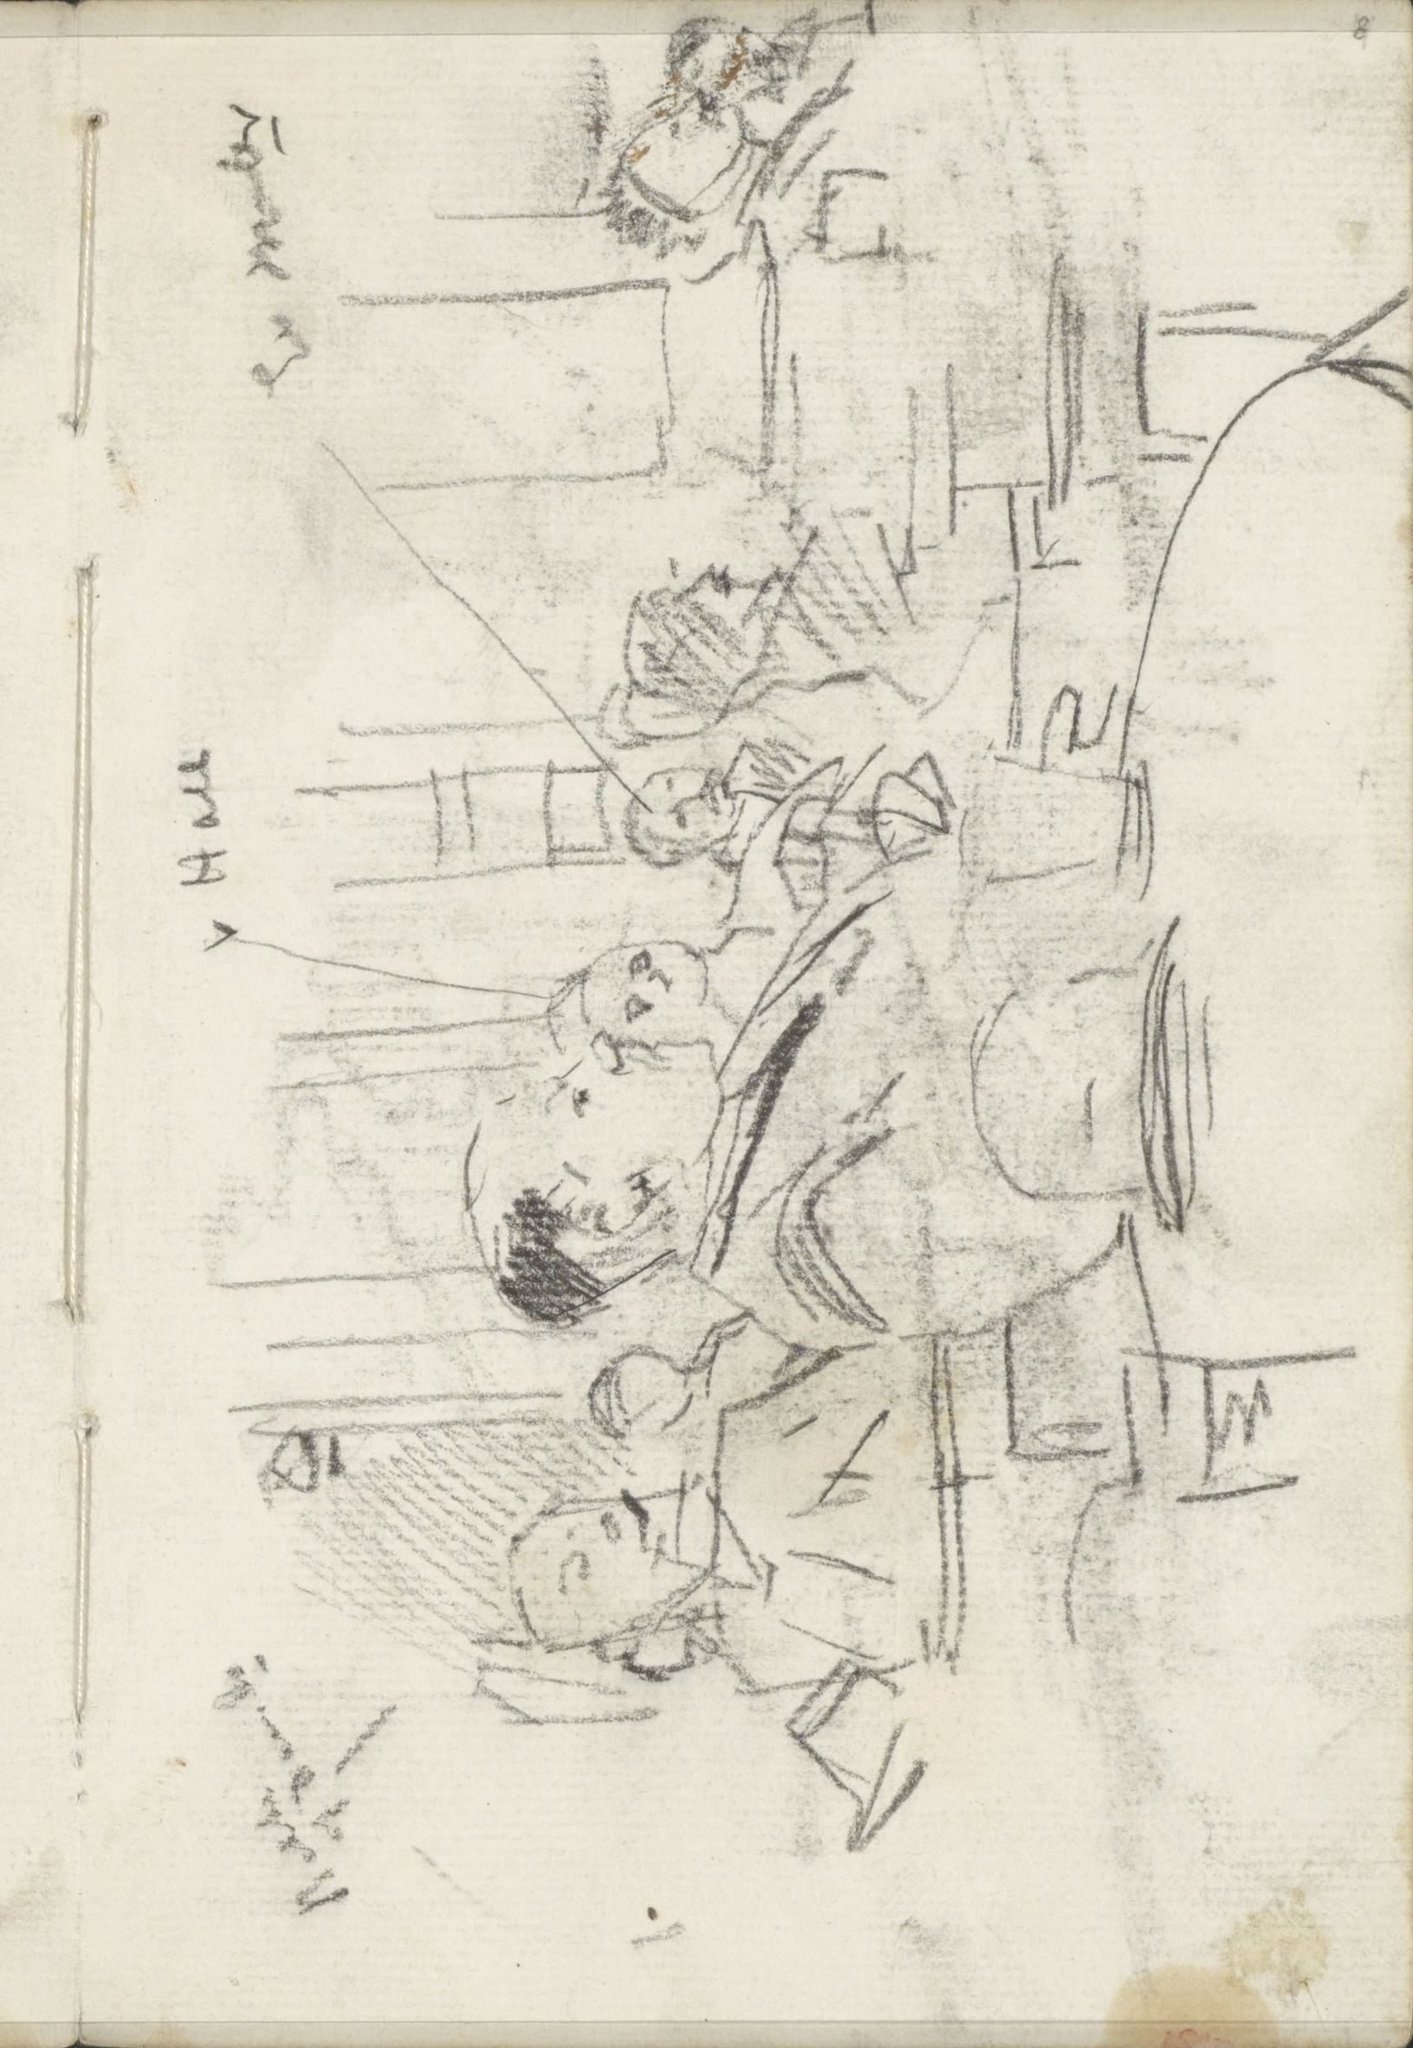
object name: sketchbook leaf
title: Mannen aan tafels, onder andere Van Hall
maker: george hendrik breitner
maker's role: draughtsman, painter, print maker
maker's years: 1857-1923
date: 1895-1898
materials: chalk, paper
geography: amsterdam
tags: adult man, table, sitting on an elevation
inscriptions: name: ‘[...]/ v. Hall/ [...]’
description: Pagina 8 uit een schetsboek met 20 bladen.